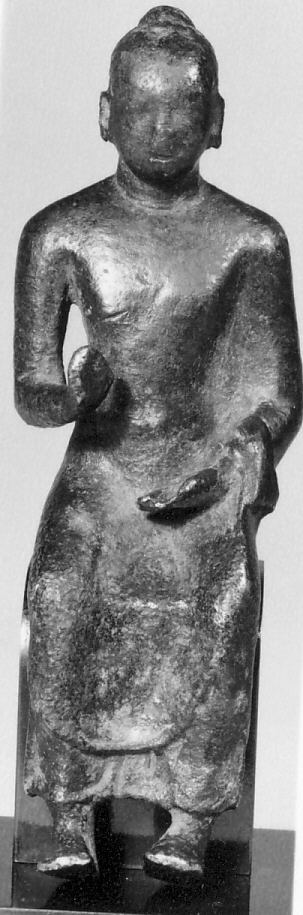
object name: figurine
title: Seated Maitreya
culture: indonesian, javanese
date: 801-900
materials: bronze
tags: buddhism,maitreya